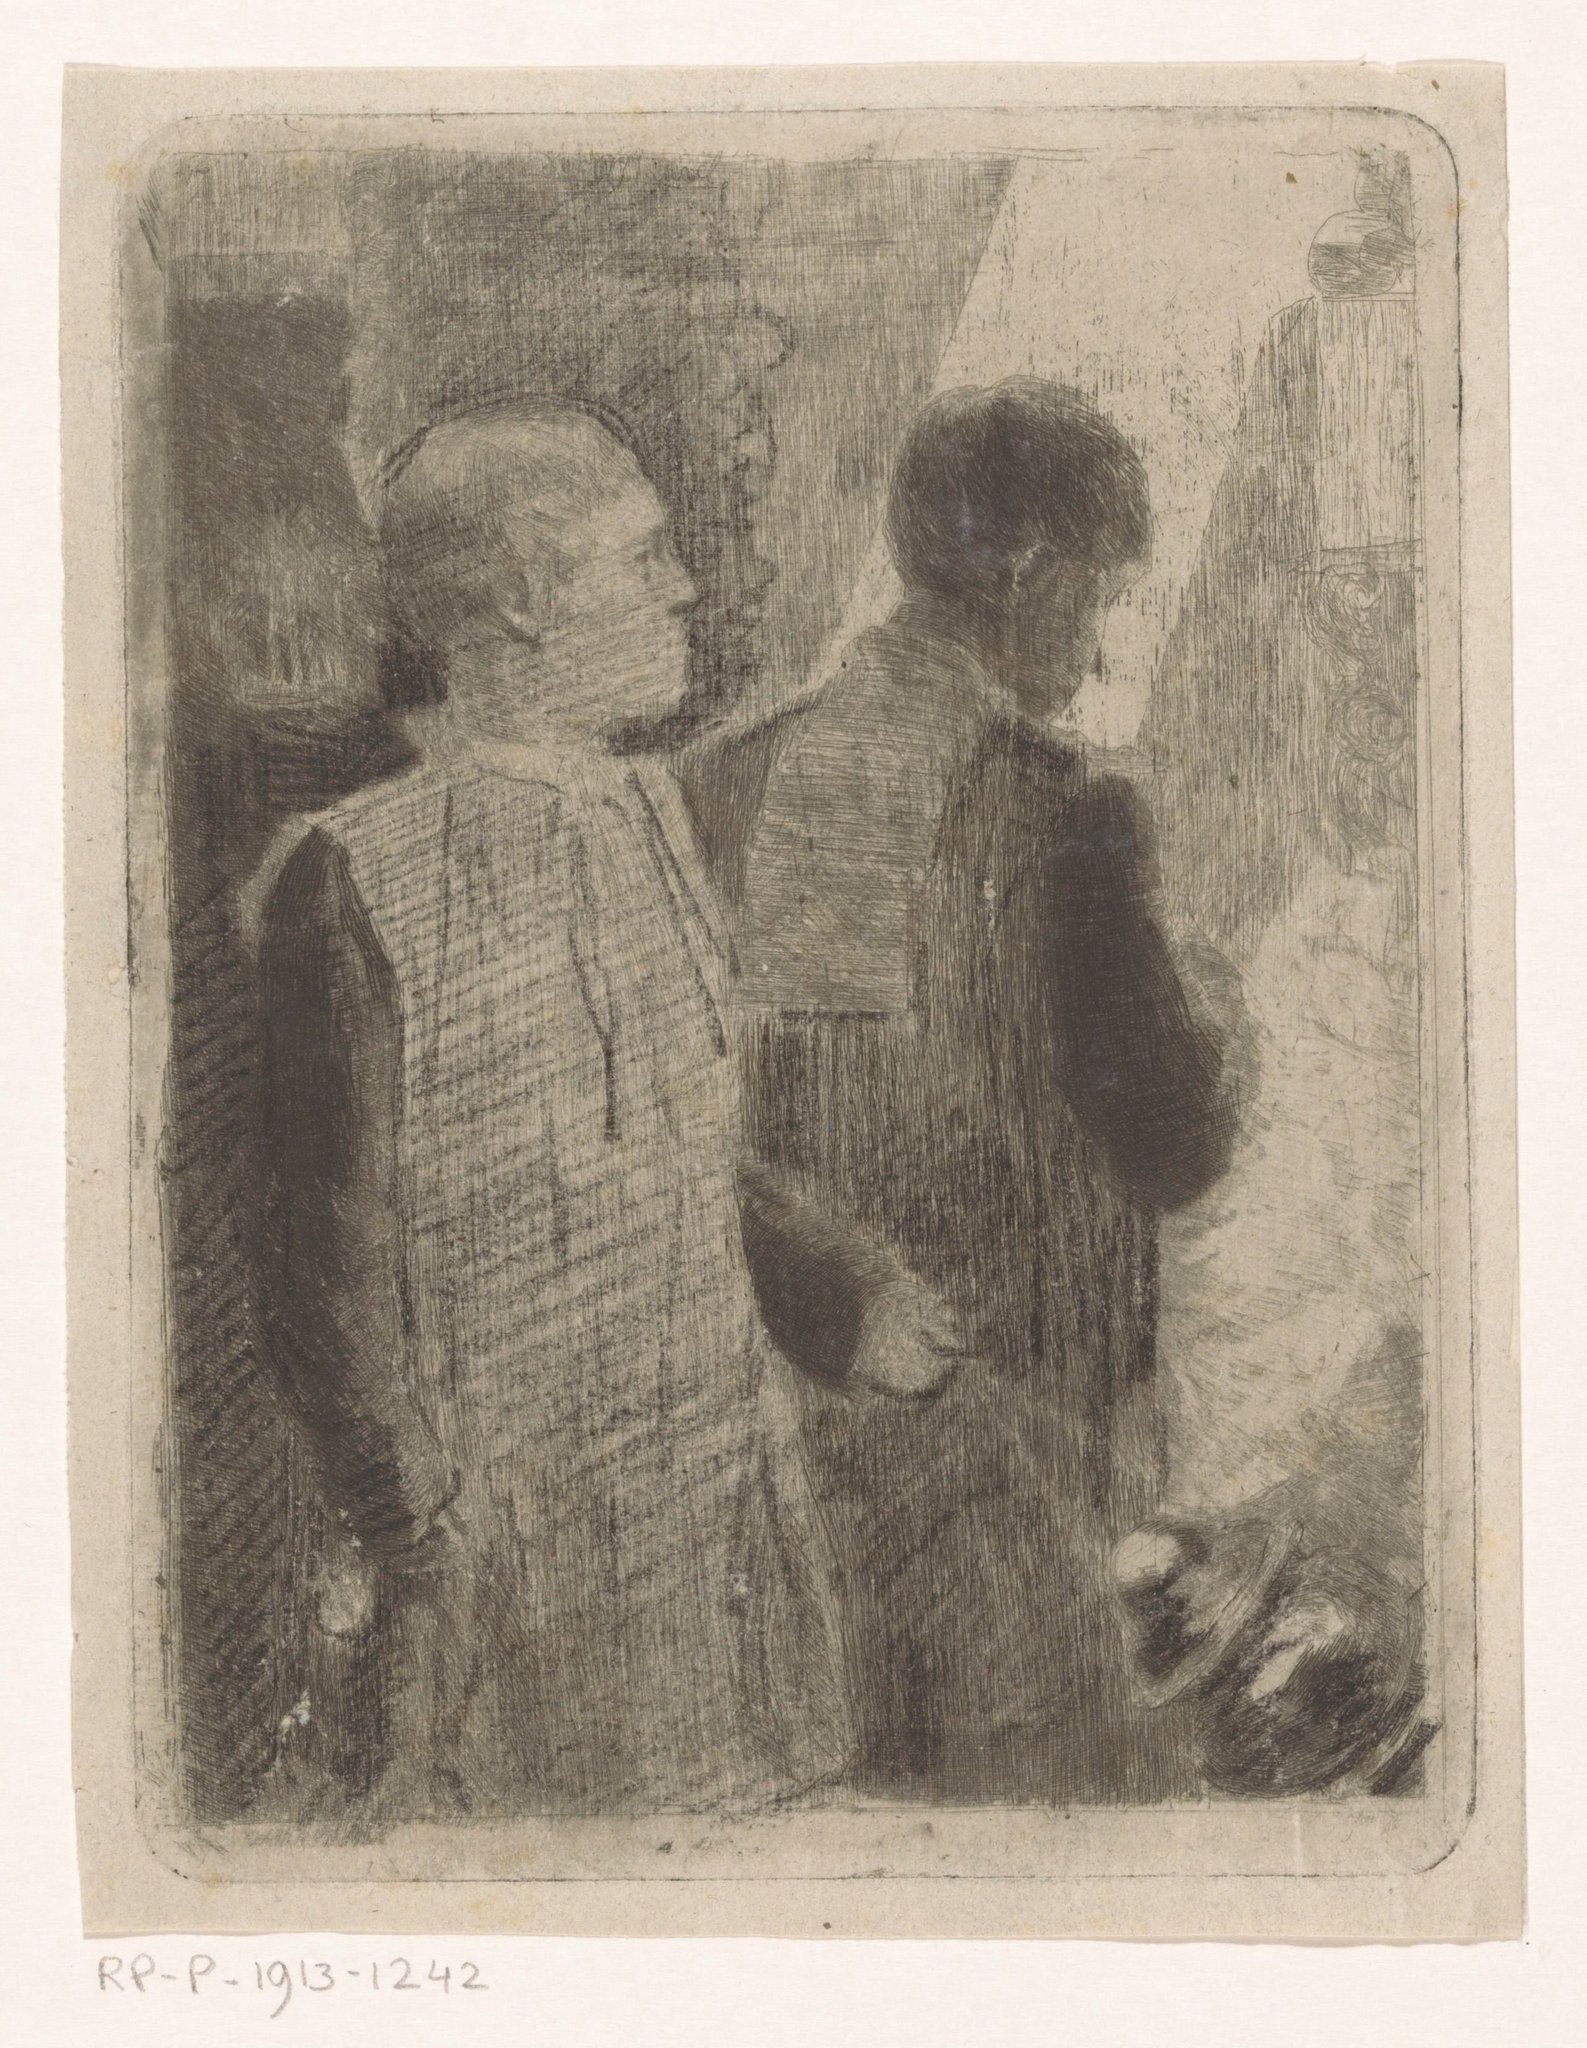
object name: print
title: Twee kinderen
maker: marinus van der maarel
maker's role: draughtsman, painter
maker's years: 1857-1921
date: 1867-1913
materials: paper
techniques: etching, soft ground etching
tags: boy (child between toddler and youth), dress, gown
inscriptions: collector's mark: Lugt 2228, collector's mark: Lugt 2233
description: Twee kinderen in toga, mogelijk koorknapen.